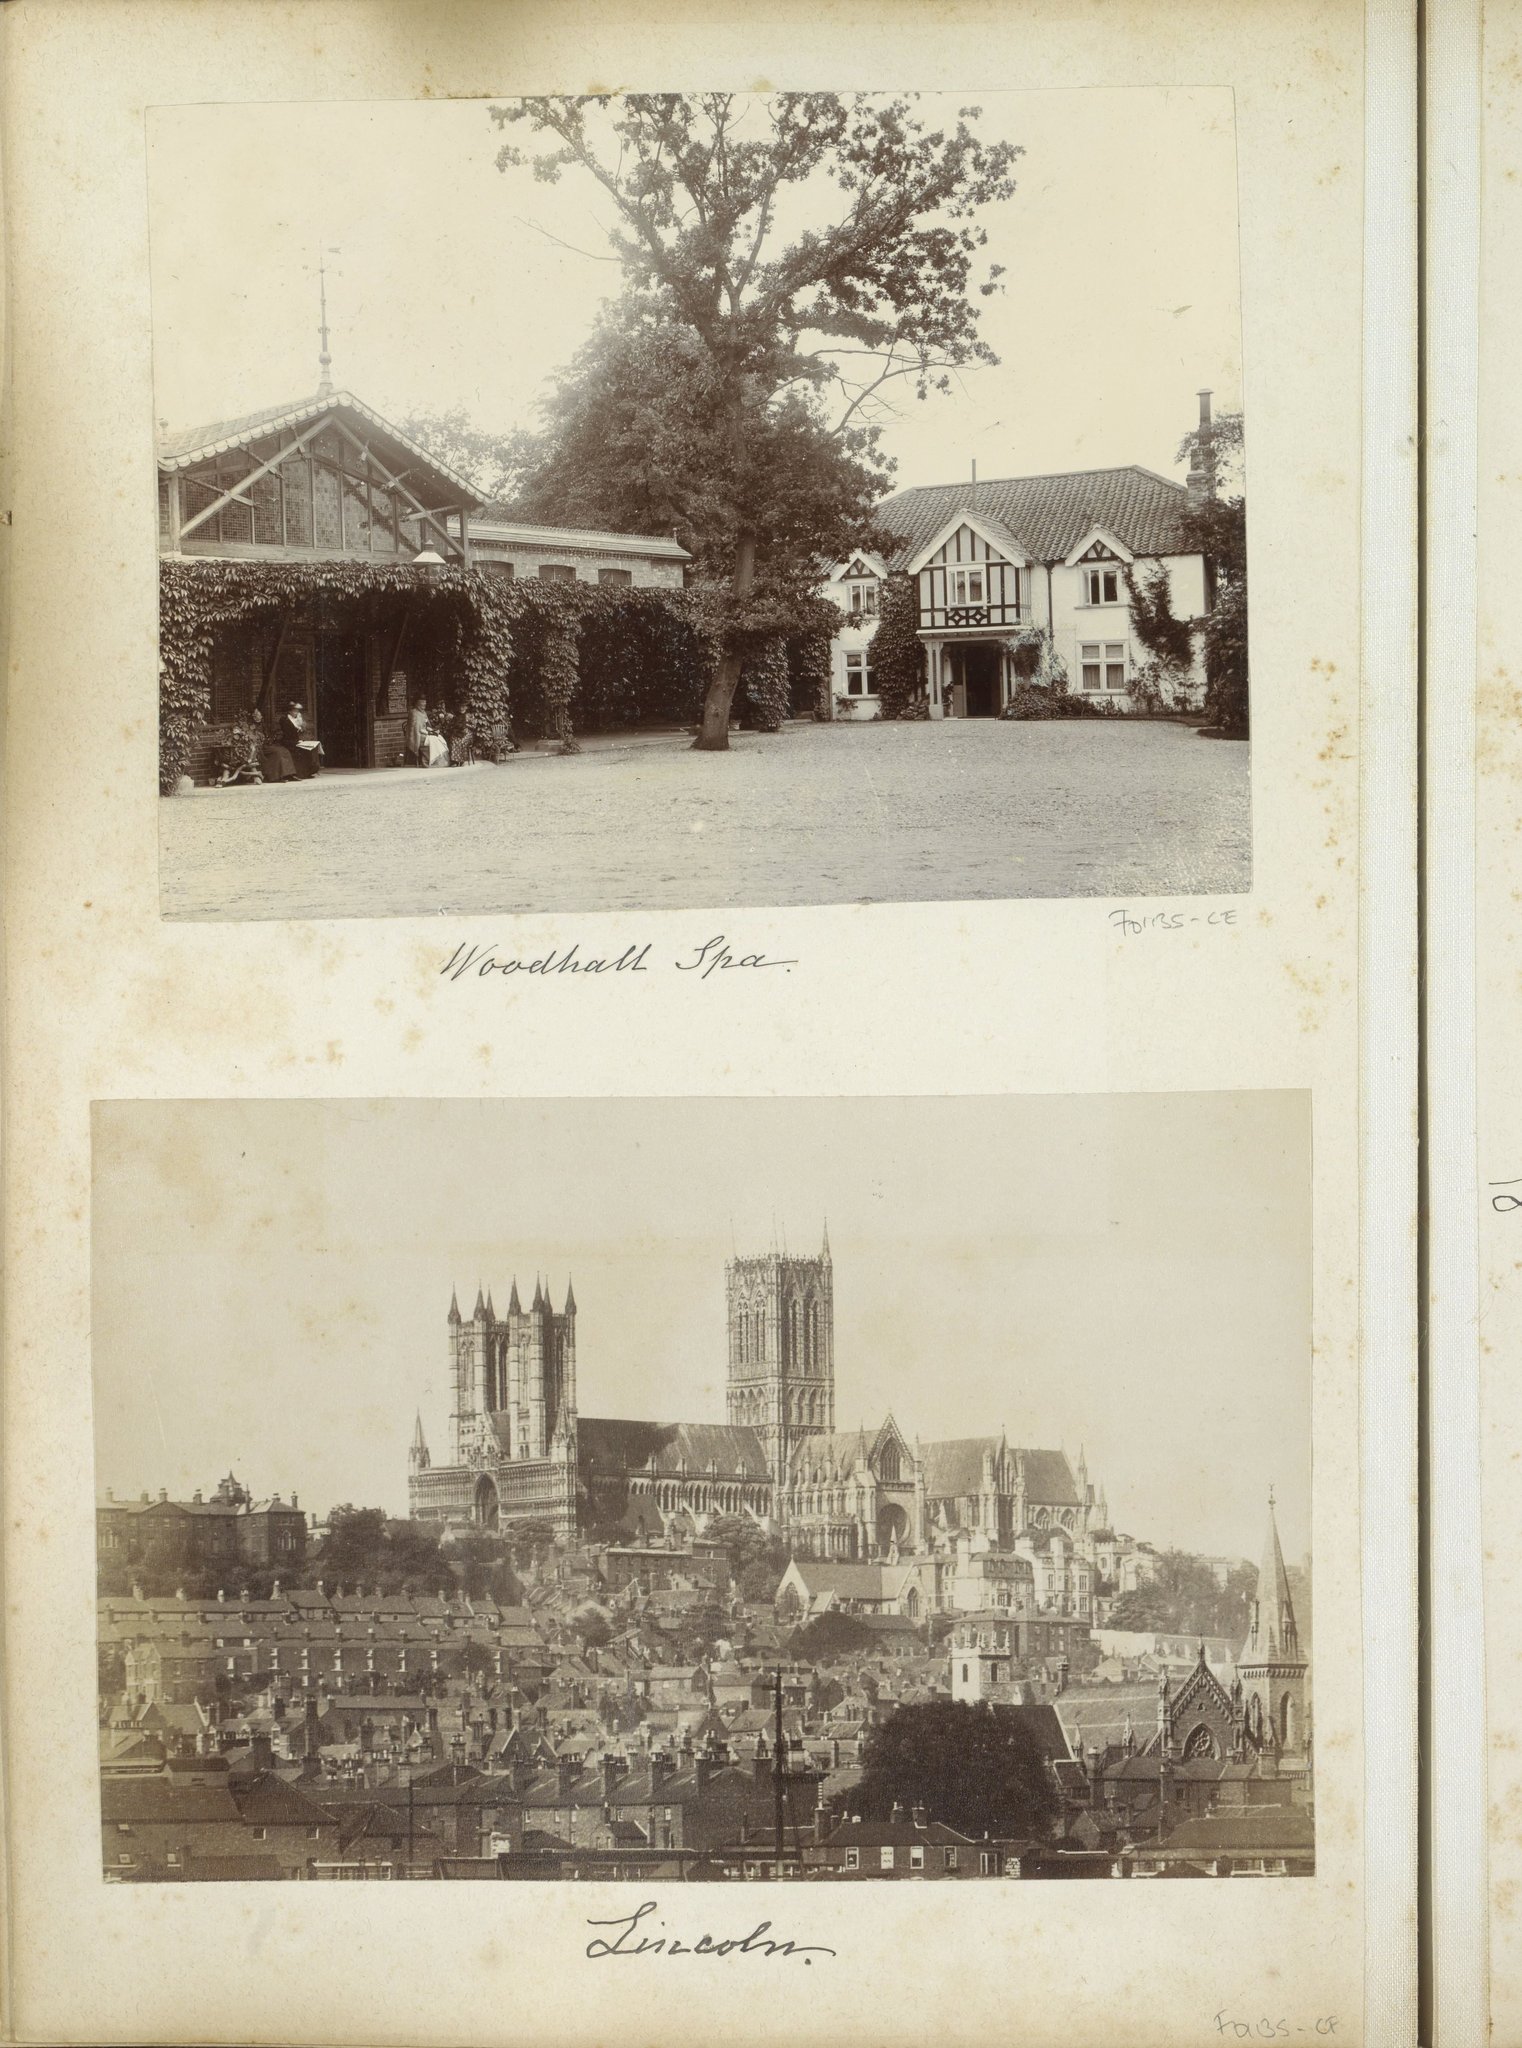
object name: album leaf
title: Gezicht op Lincoln en de kathedraal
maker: Anonymous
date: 1900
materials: paper, photographic support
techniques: albumen print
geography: lincoln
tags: church (exterior), prospect of city, town panorama, silhouette of city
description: Onderdeel van Reisalbum met foto's van bezienswaardigheden in Engeland en Frankrijk.